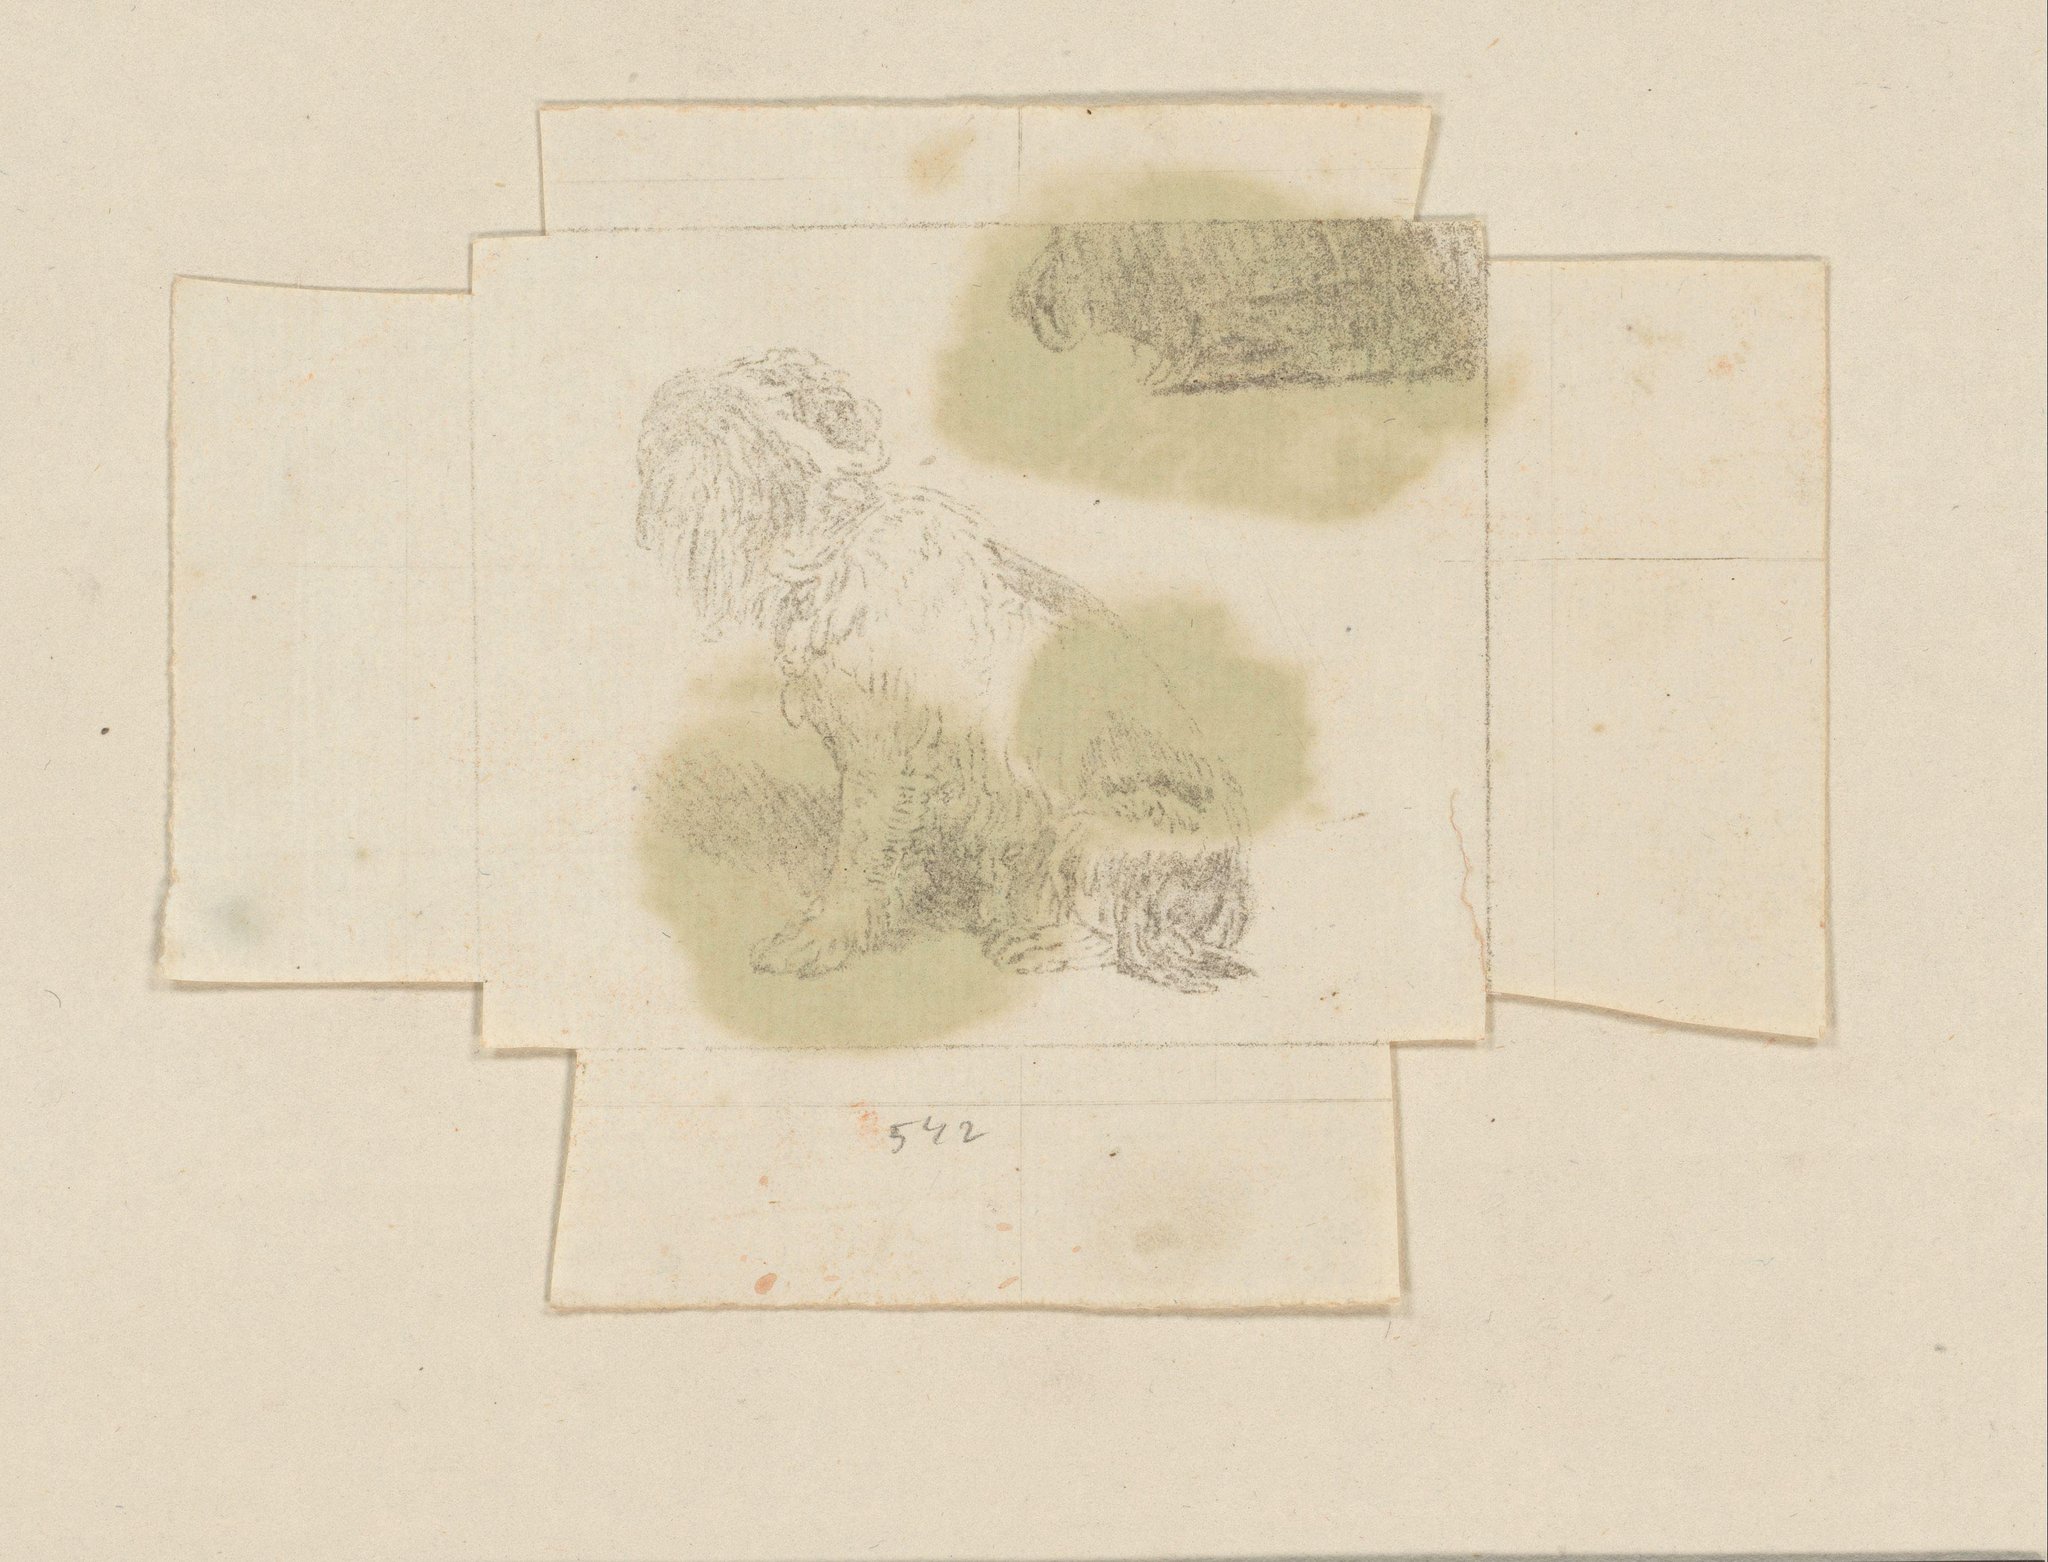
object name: drawing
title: Zittende hond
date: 1777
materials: chalk, paper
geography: amsterdam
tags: dog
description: Over de doordruktekeningen van Ploos van Amstel zie LNP, p. 201.